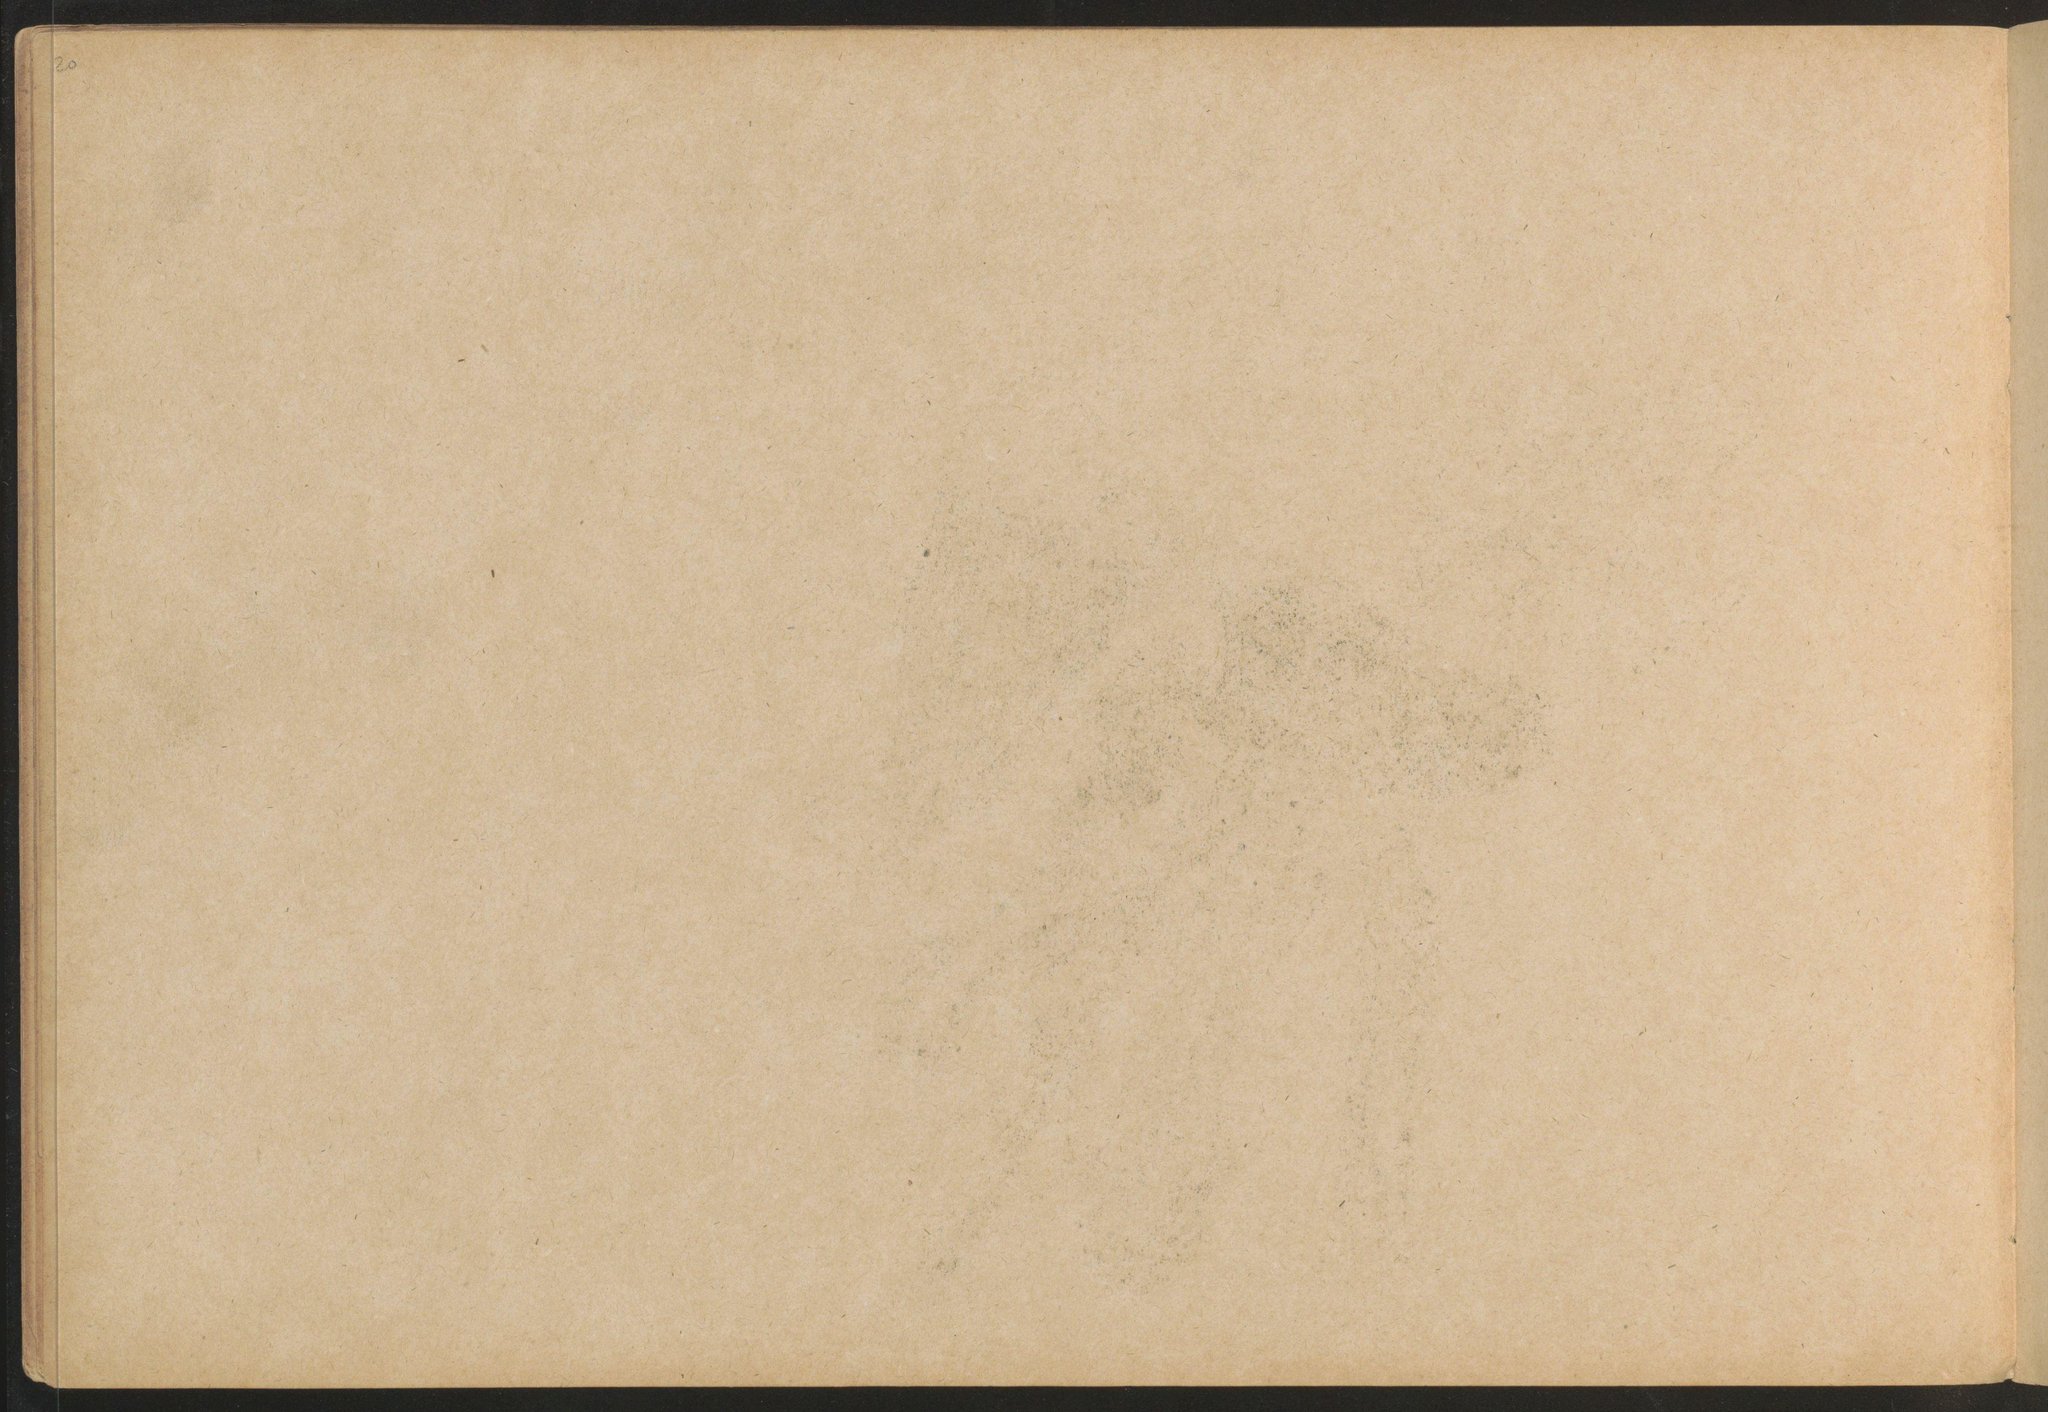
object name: sketchbook leaf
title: Abklatsch van de krijttekening op pagina 21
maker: willem witsen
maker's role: draughtsman, painter, print maker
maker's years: 1860-1923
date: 1884-1887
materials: paper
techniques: printmaking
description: Pagina 20 uit een schetsboek met 29 bladen.